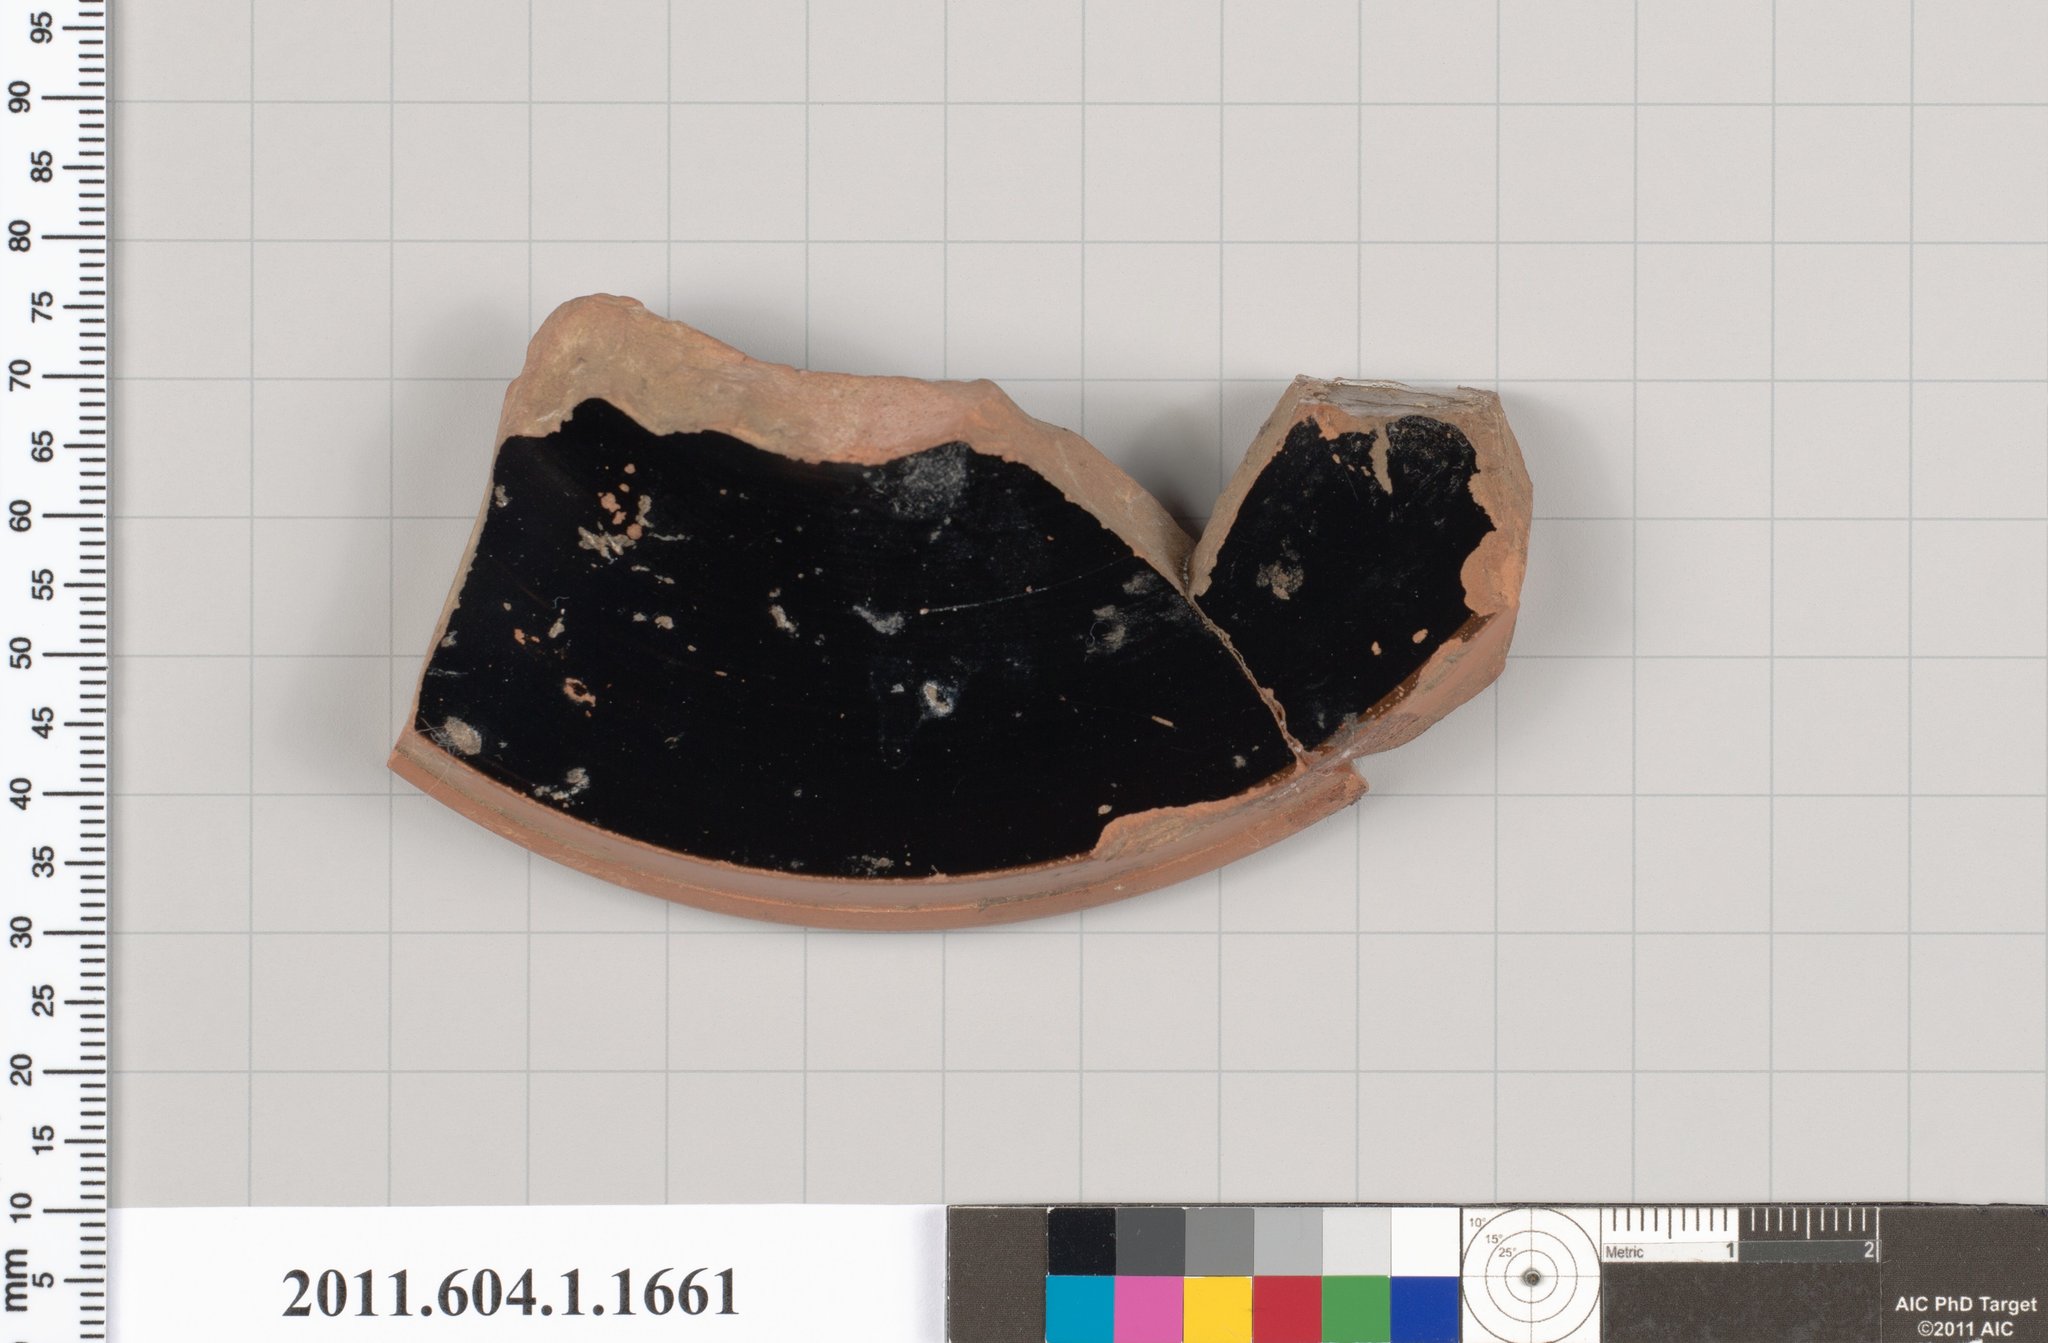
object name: kylix fragment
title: Terracotta fragment of a kylix (drinking cup)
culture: greek, attic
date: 530-510 BCE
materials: terracotta